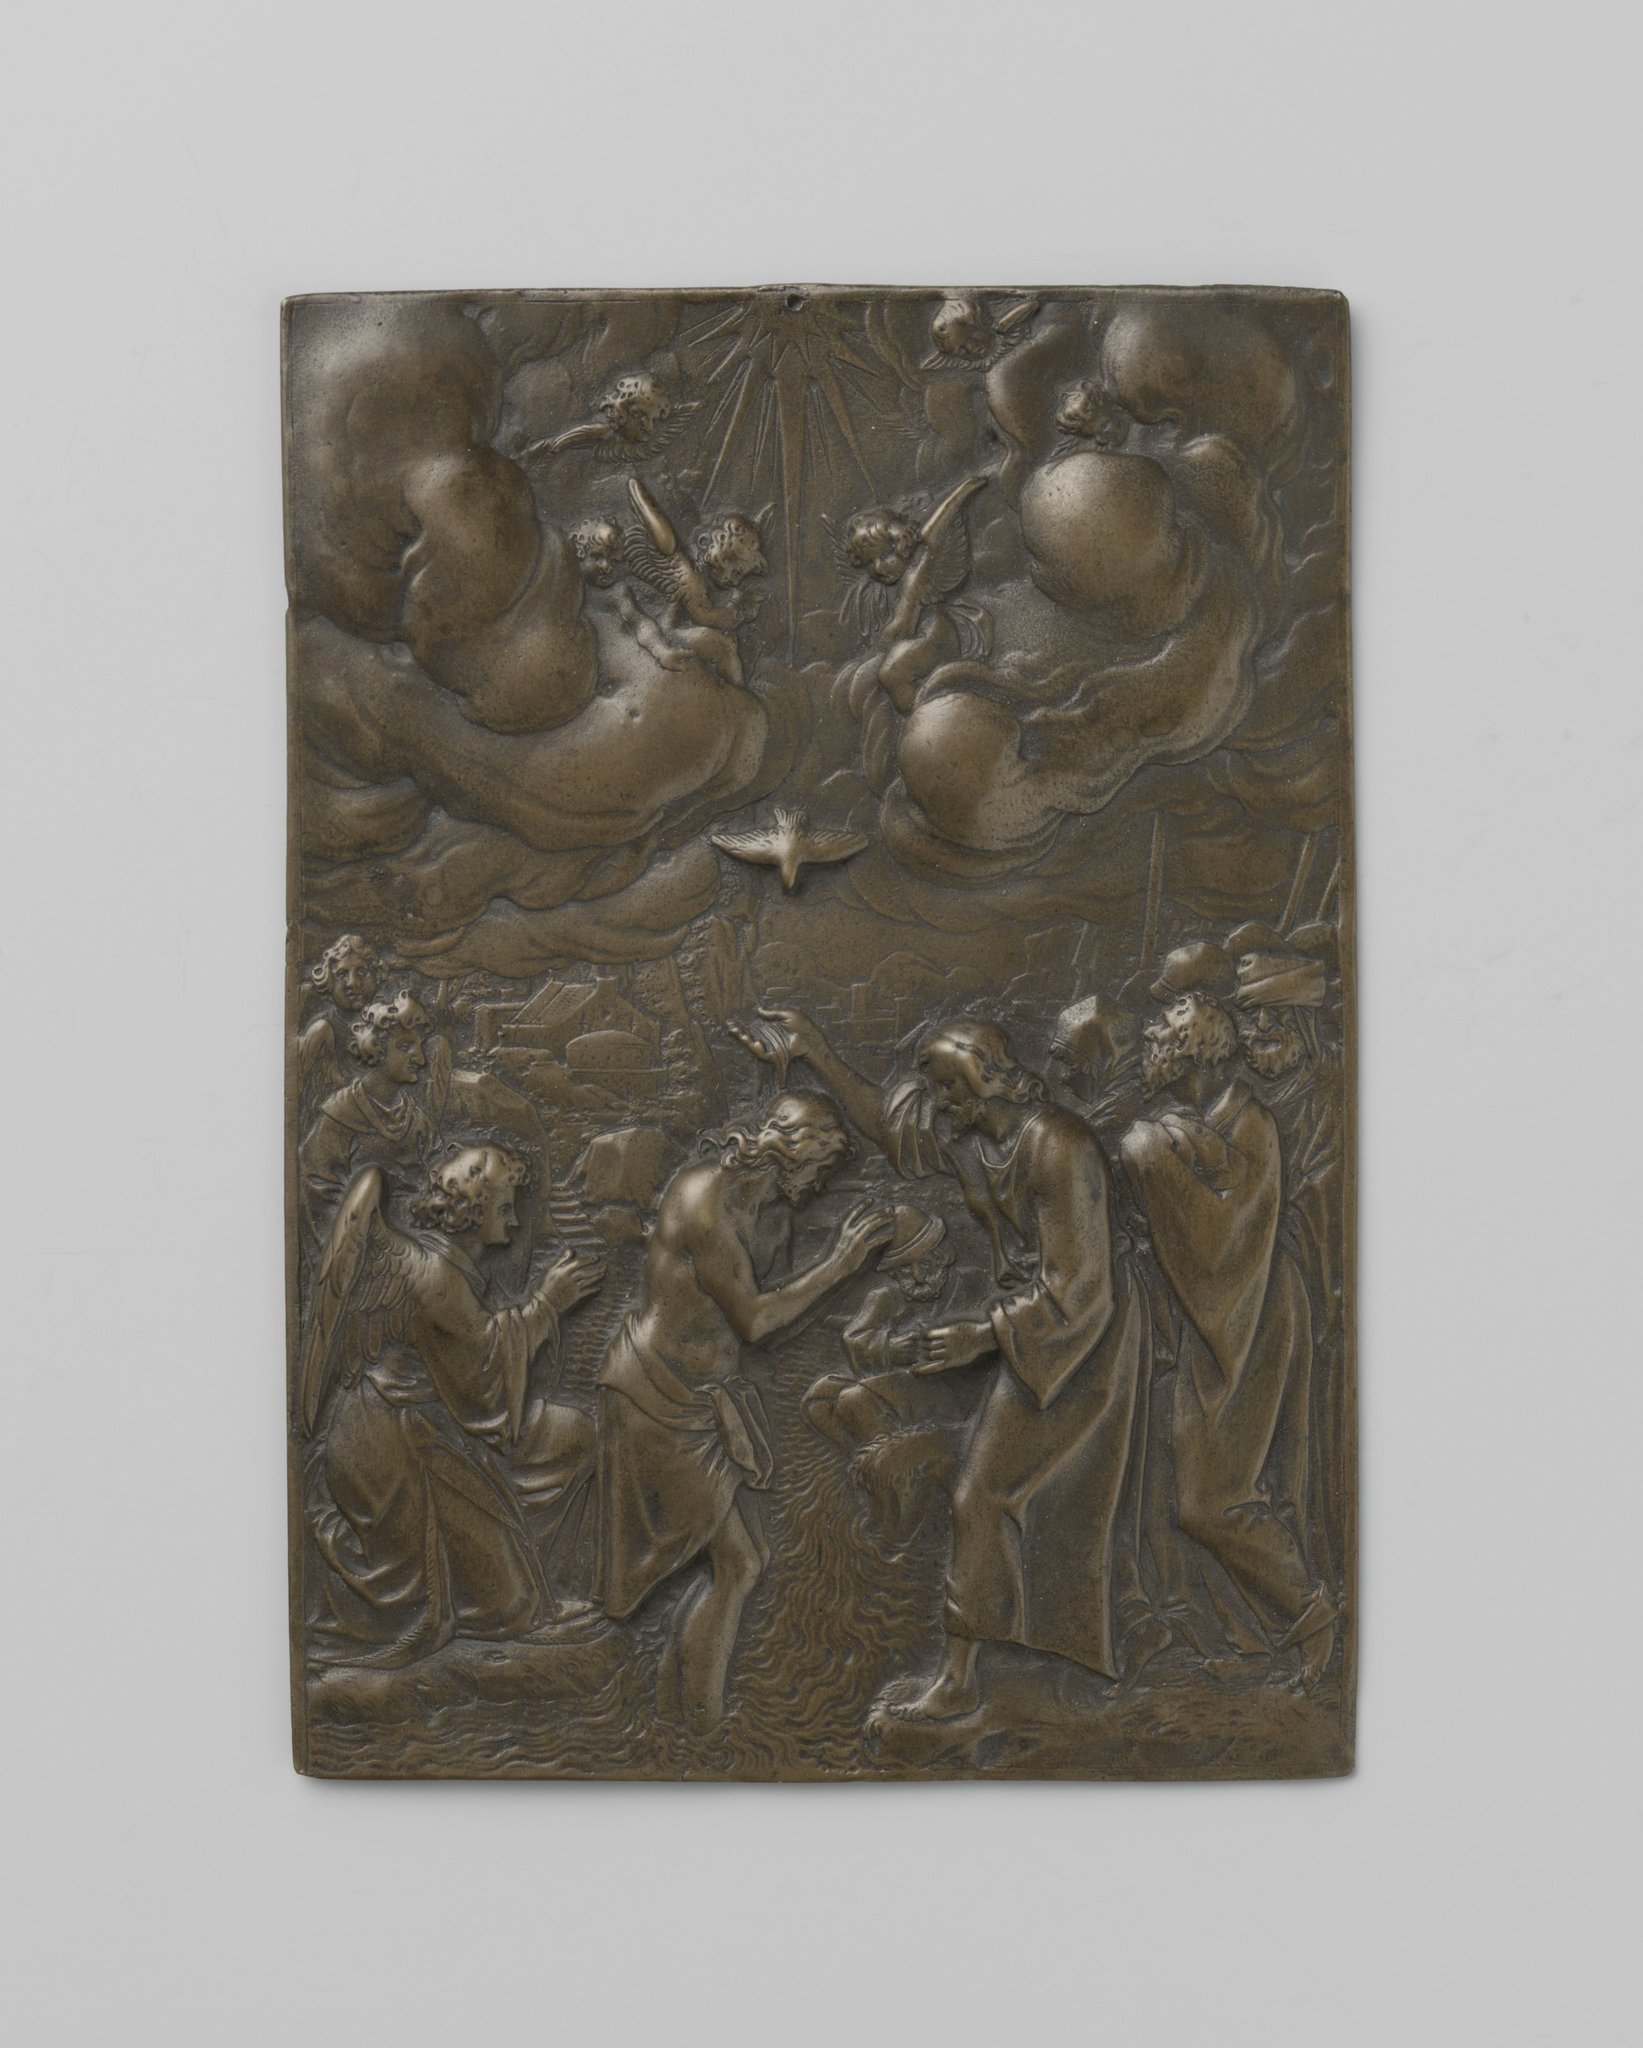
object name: plaque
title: Plaquette met de Doop van Christus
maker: arent van bolten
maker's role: draughtsman, print maker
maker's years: 1573-1633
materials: bronze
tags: baptism of christ in the river jordan: john the baptist pouring out water on christ's head: the holy ghost descends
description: Een plaquette van brons met een voorstelling van de Doop van Christus. In het midden links Christus en rechts Johannes de Doper. Tussen deze, iets naar de achtergrond, een zittende oude man.